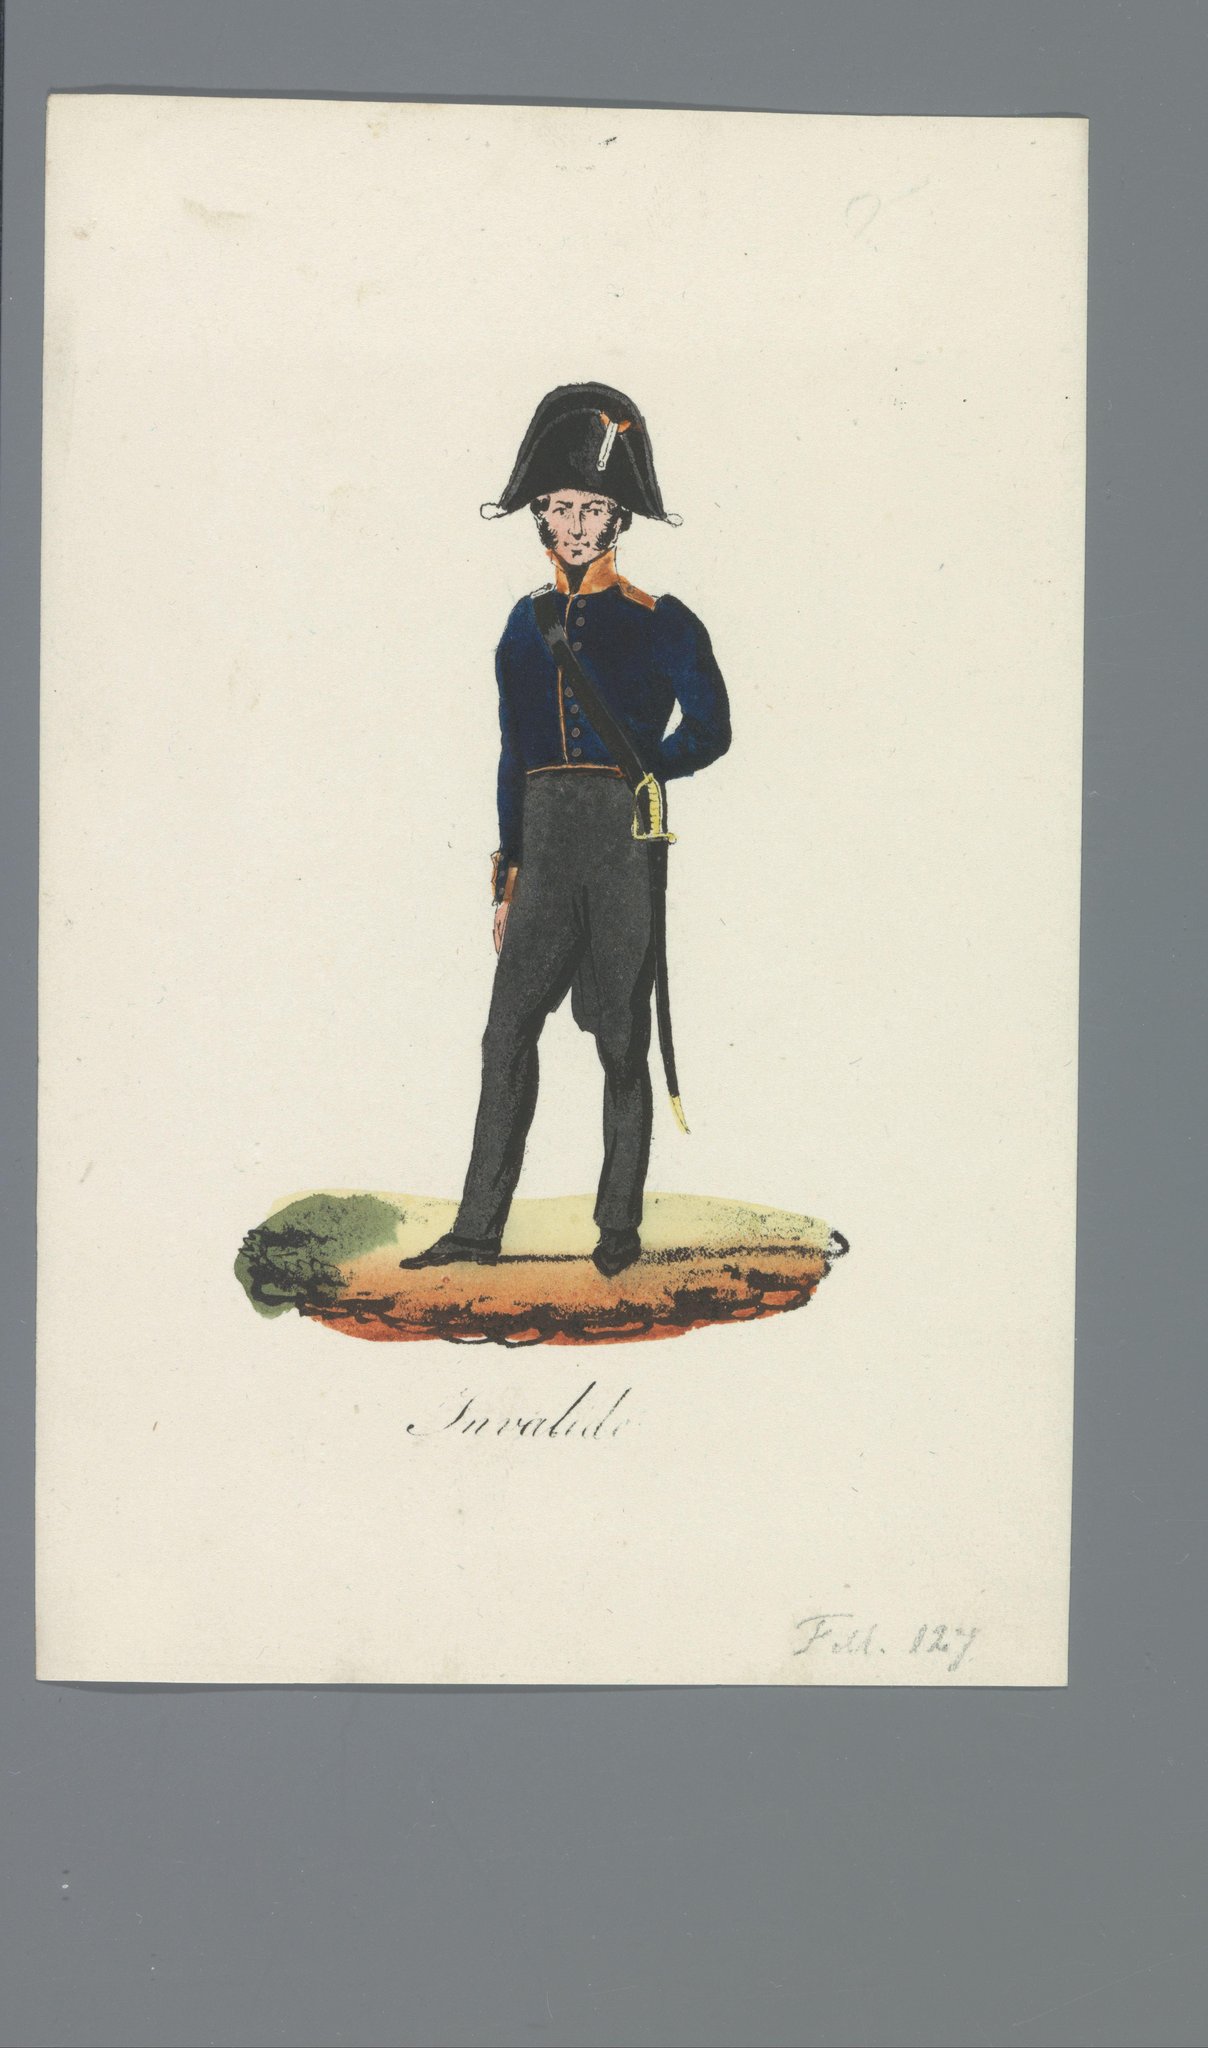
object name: costume print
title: Nederlandse militaire uniformen in de jaren 1830-1832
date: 1835-1850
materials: paper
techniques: hand coloring, lithograph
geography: netherlands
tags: disabled soldier, (military) uniforms, clothes, costume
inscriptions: collector's mark: Lugt 2228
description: Een invalide militair, te voet. Onderdeel van een serie van 157 losse bladen met Nederlandse militaire uniformen in de jaren 1830-1832. Het woord invalide werd gebruikt als aanduiding voor militairen die gewond waren geraakt in de oorlog en droeg een zekere mate van respect uit.